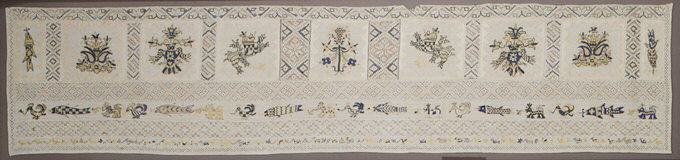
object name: cover fragment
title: Portion of a cover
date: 1701-1800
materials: linen, silk